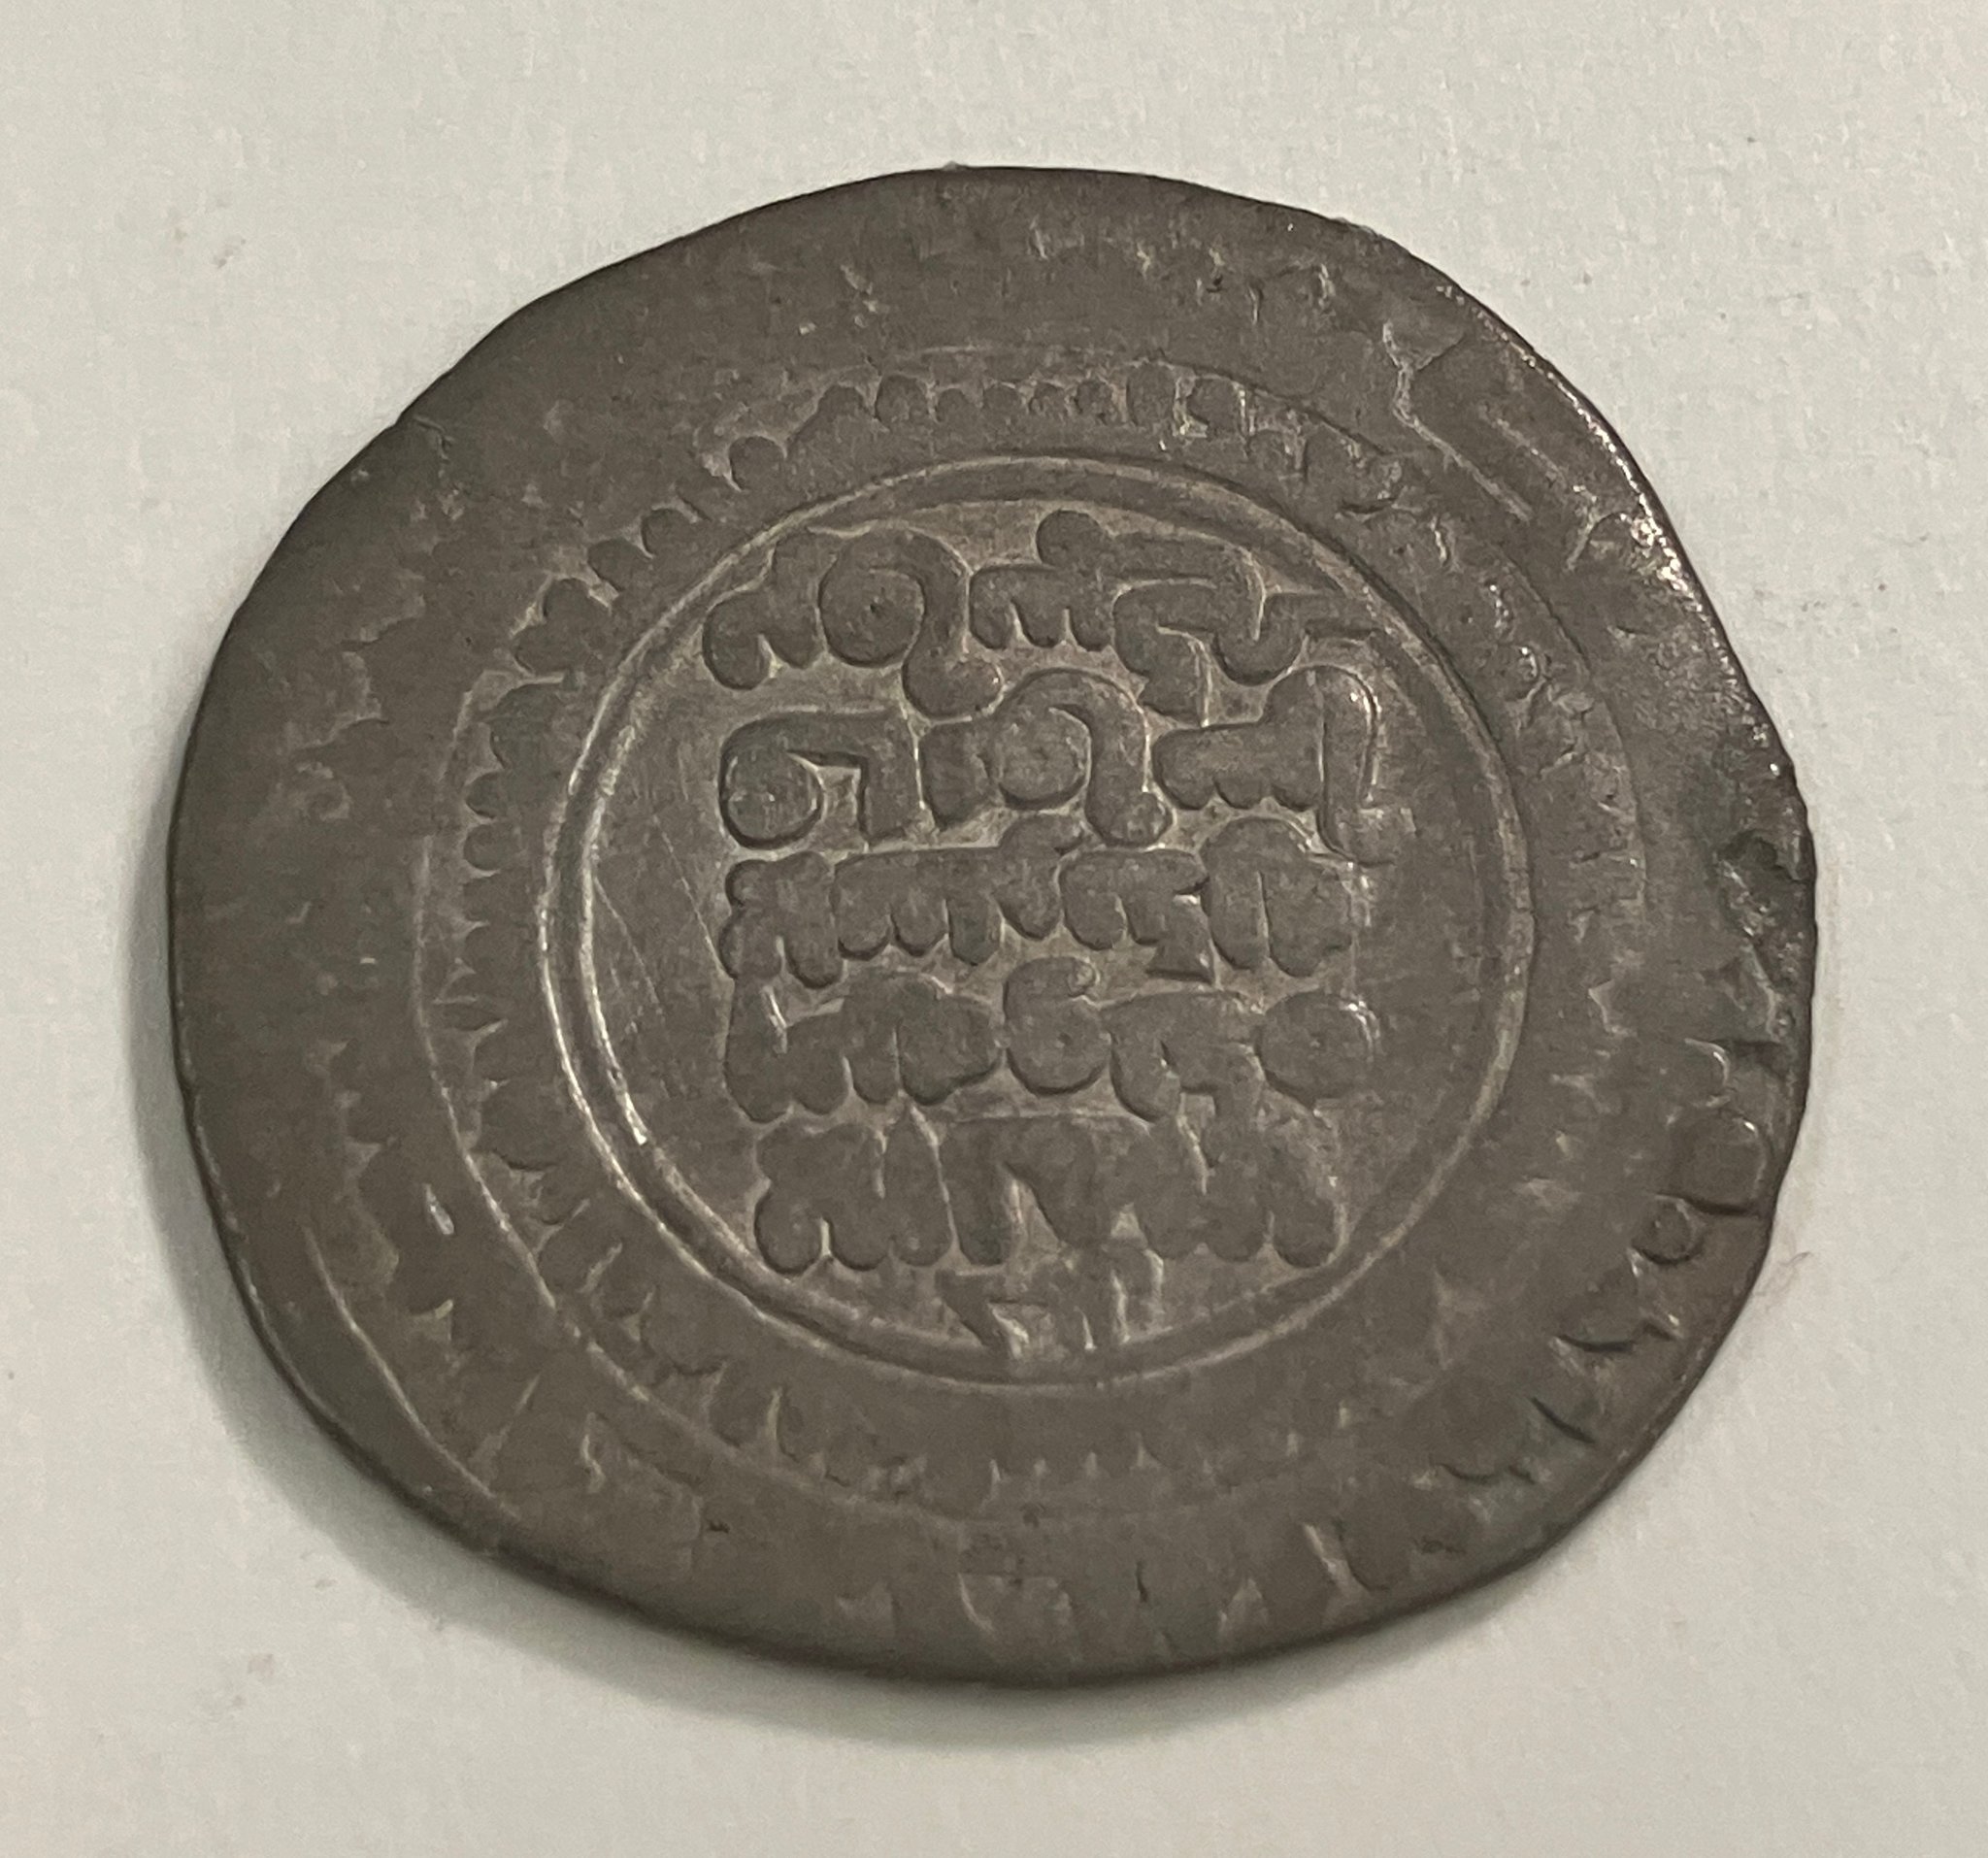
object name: coin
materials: silver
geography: iran